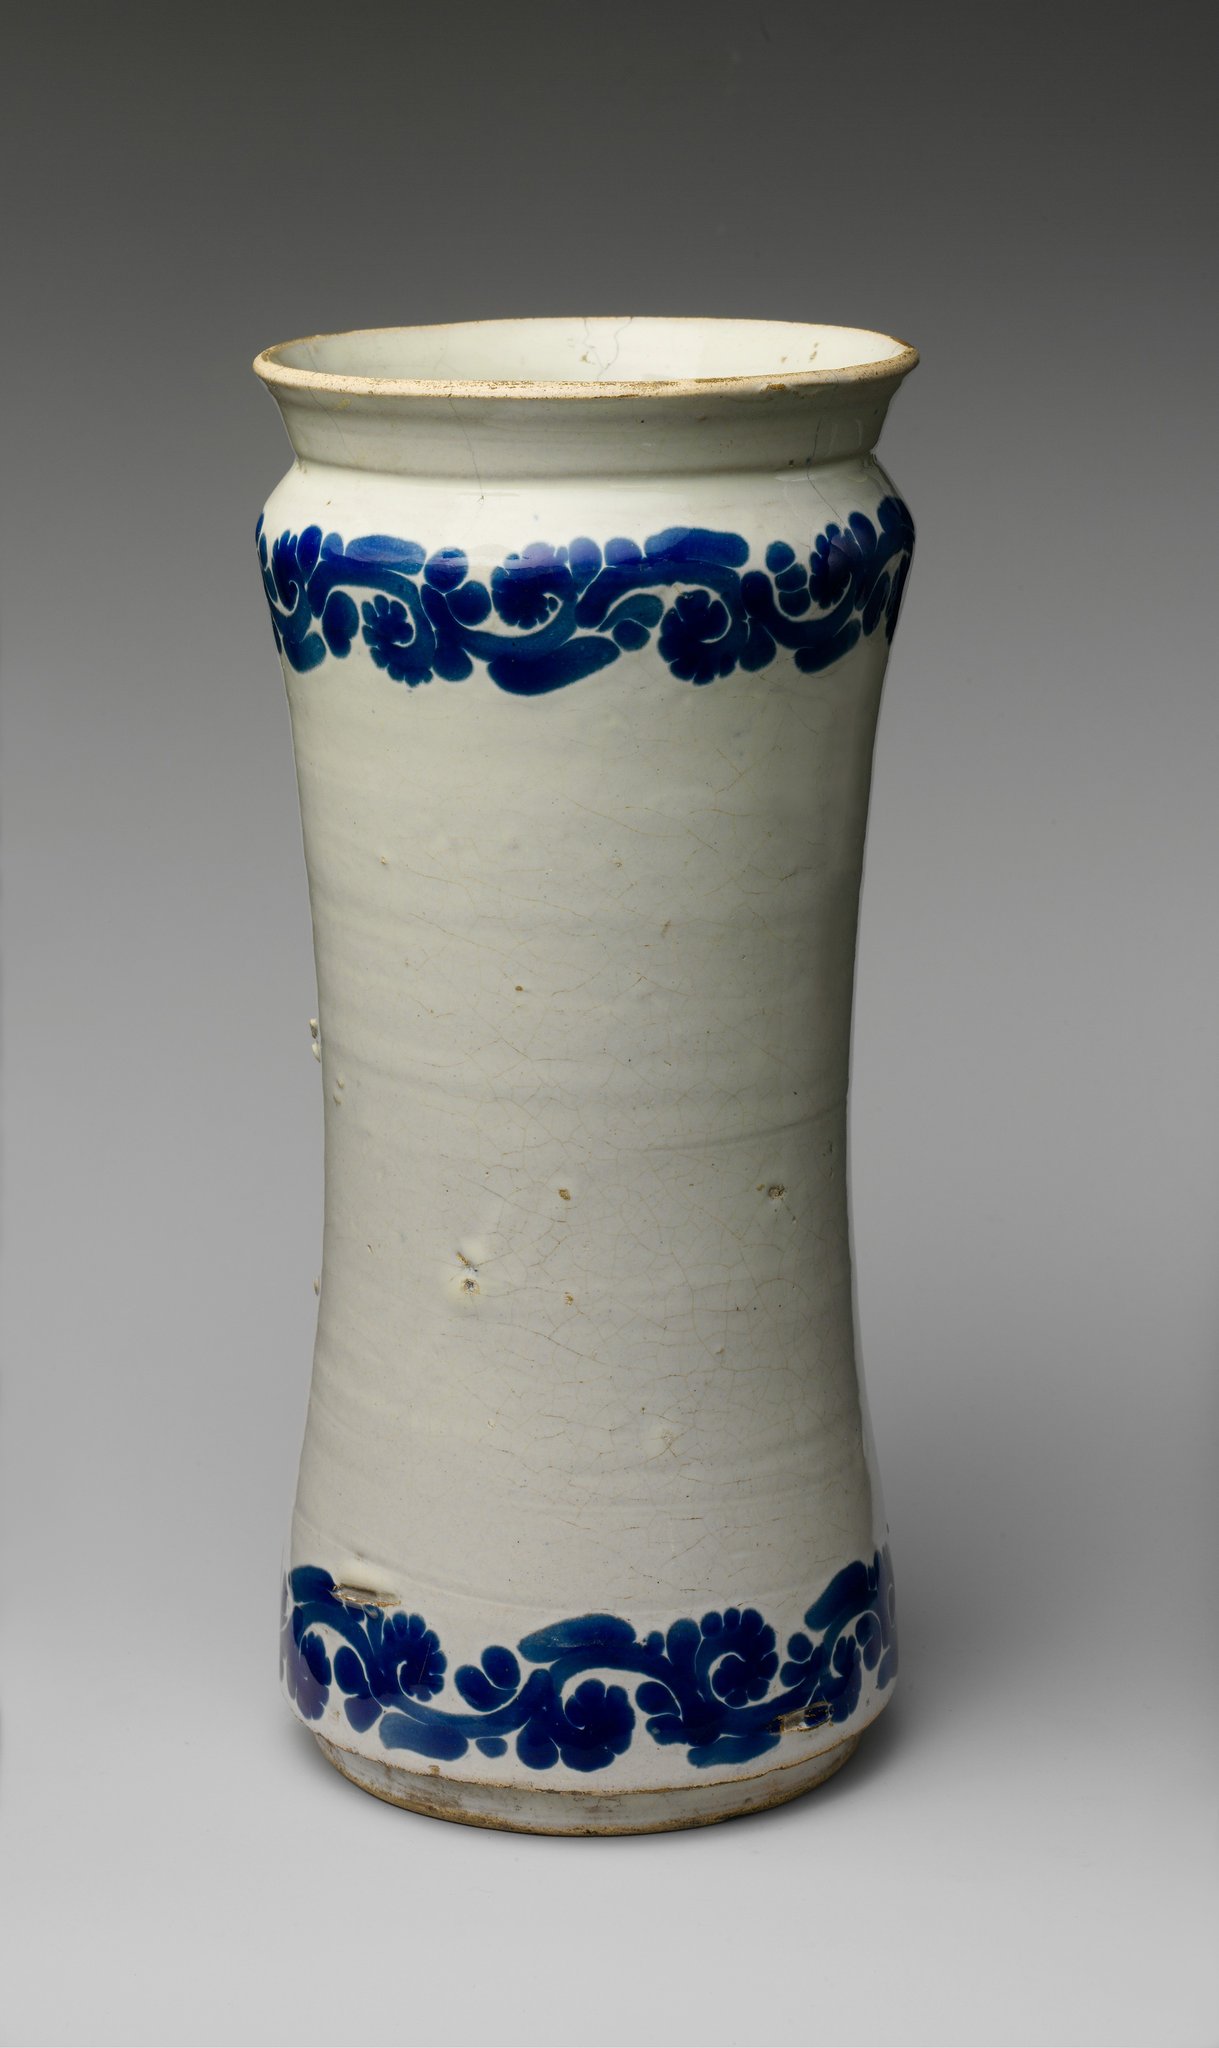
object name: apothecary jar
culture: mexican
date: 1750-1800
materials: earthenware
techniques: glazing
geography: mexico